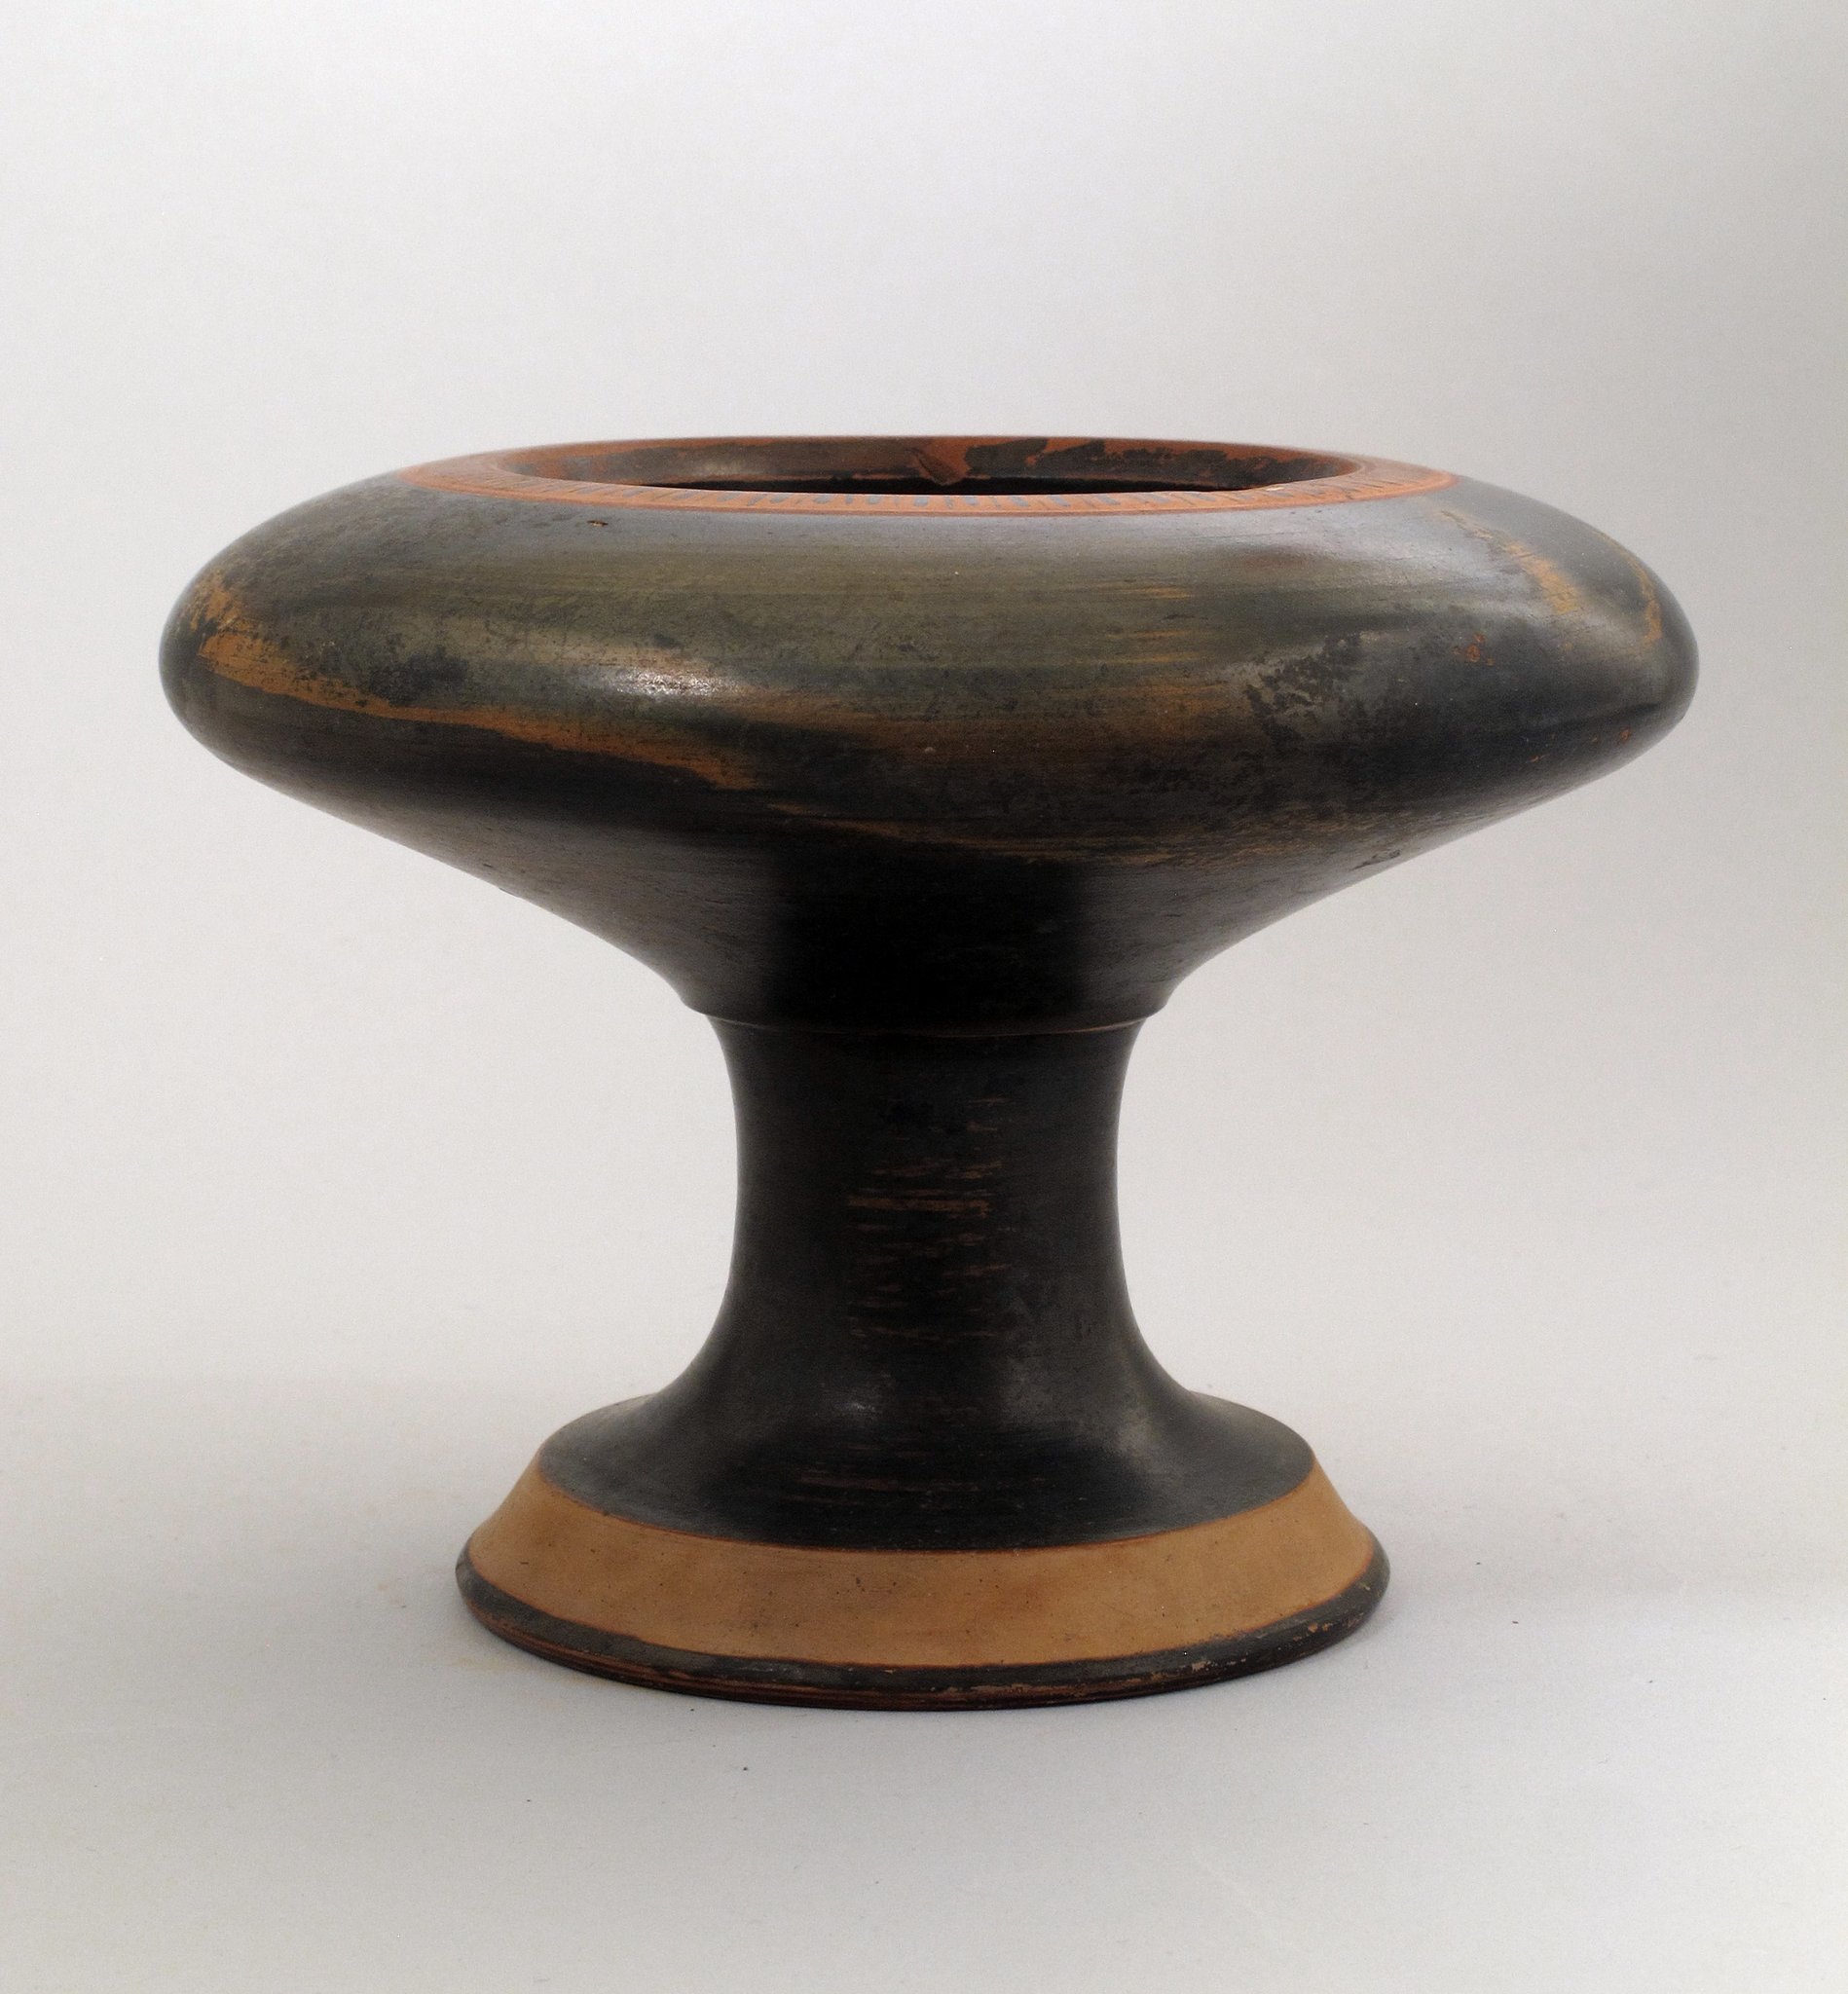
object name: plemochoe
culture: greek, attic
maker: kothons type b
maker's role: artist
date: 500-401 BCE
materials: terracotta